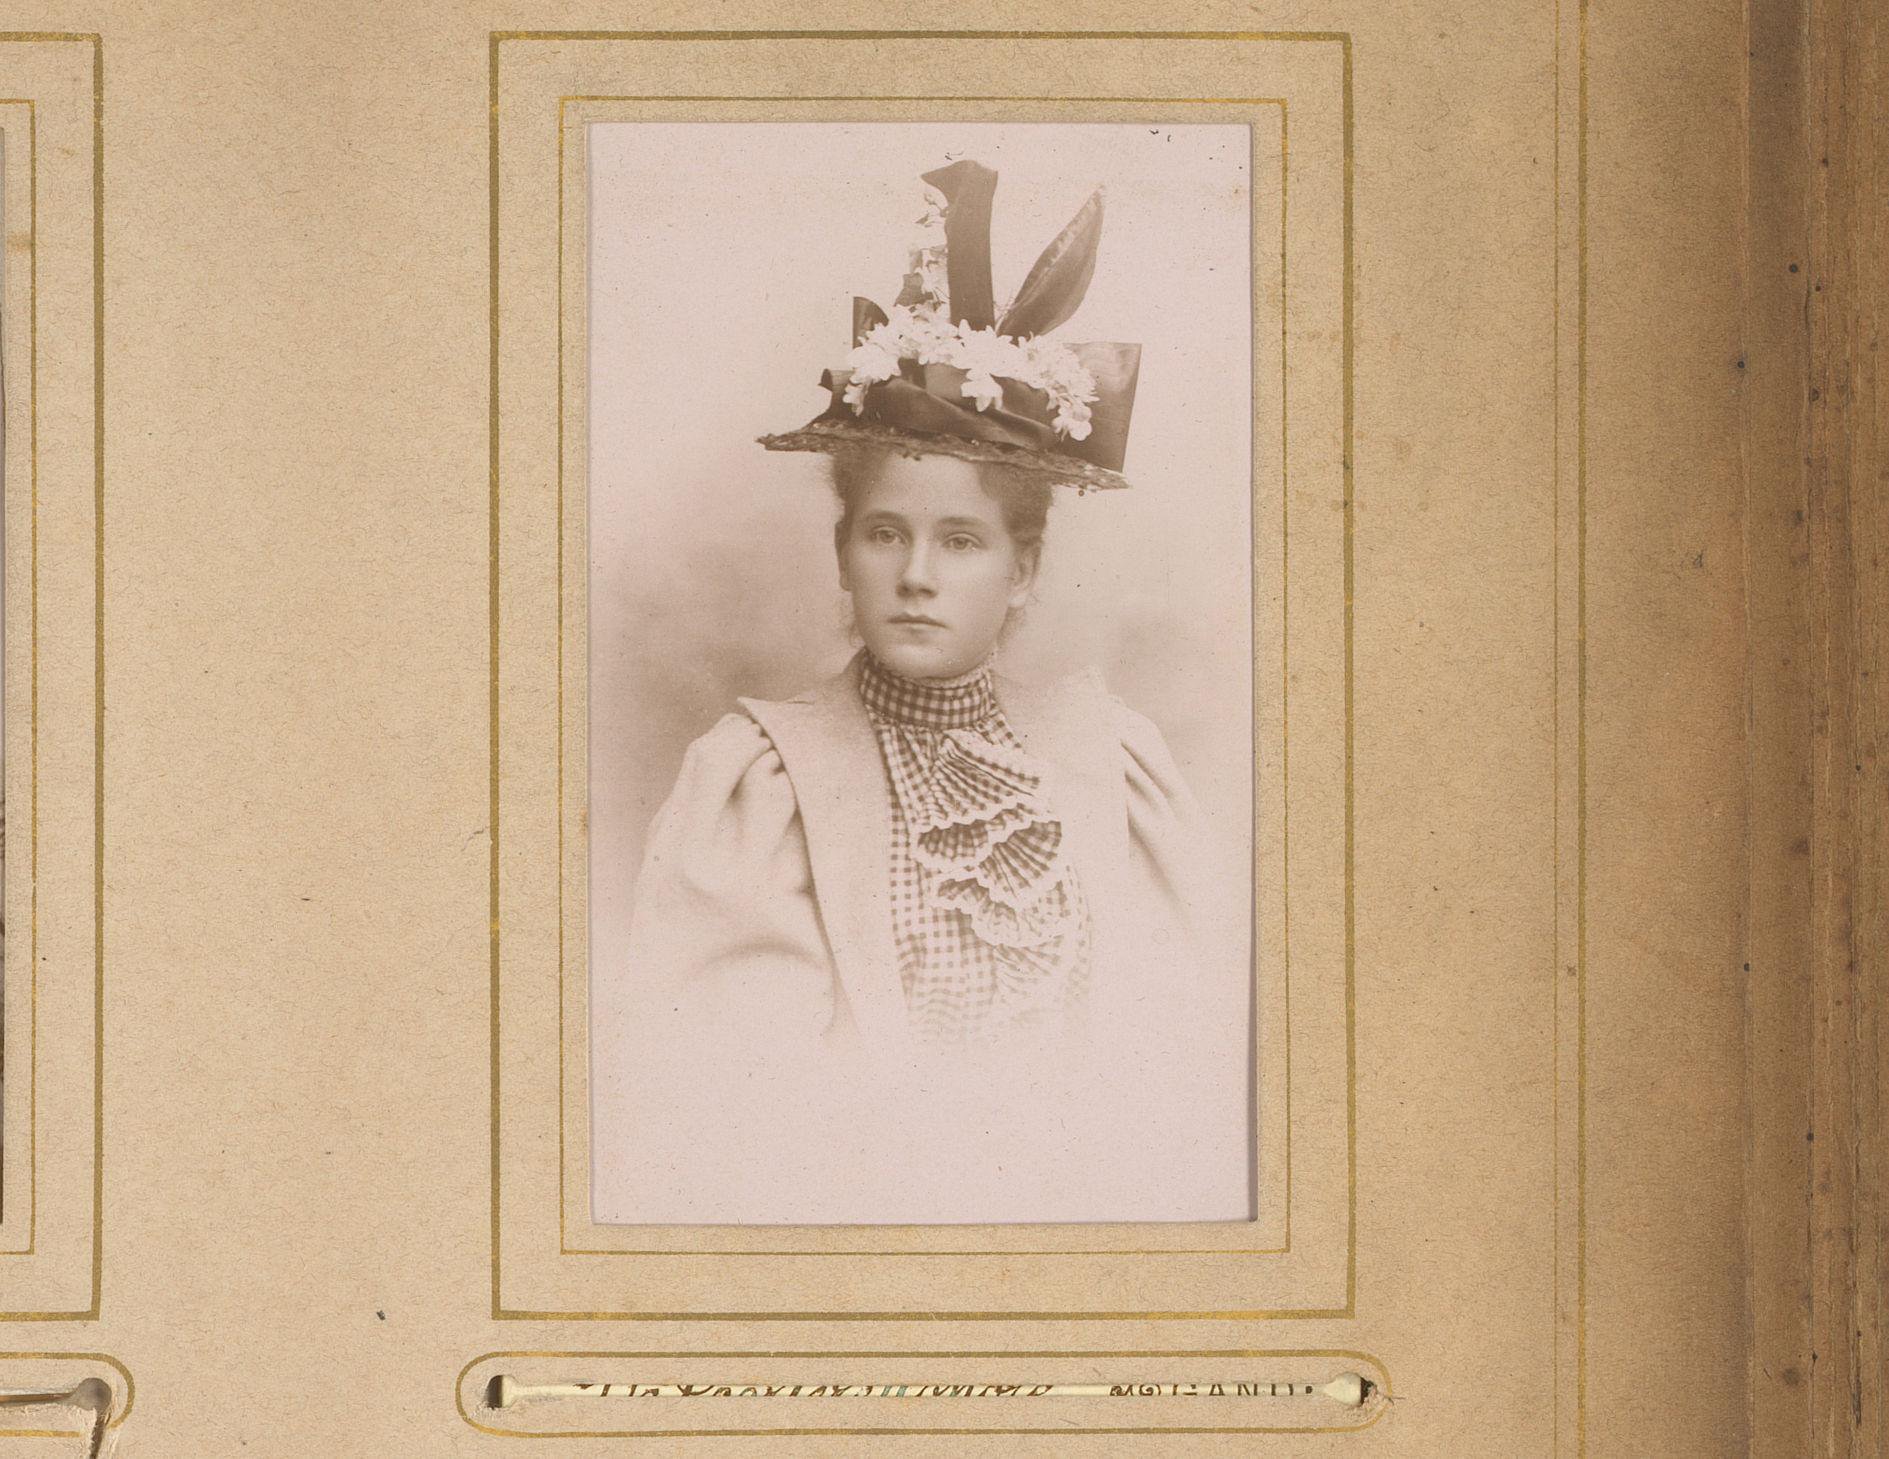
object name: album leaf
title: Portret van een vrouw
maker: honoré de poortere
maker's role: fotograaf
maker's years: 1870-1949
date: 1860-1900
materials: cardboard, photographic support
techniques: collodion silver print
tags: adult woman, historical persons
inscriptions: name: ‘Poortere, Honoré de Gand’